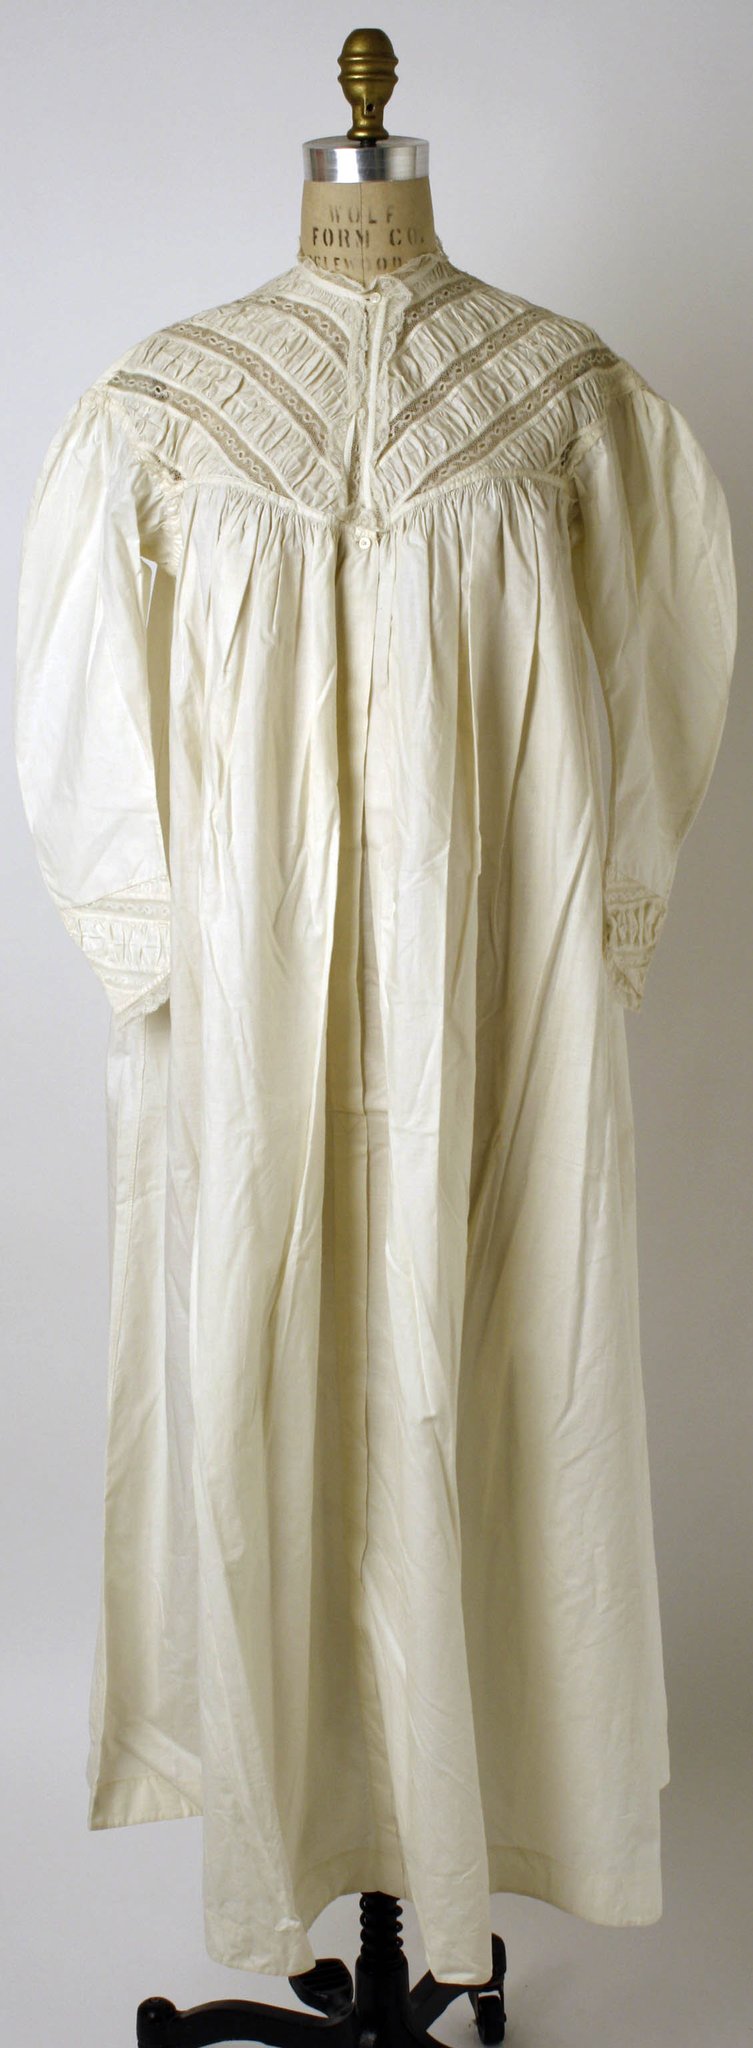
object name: nightgown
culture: american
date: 1862-1867